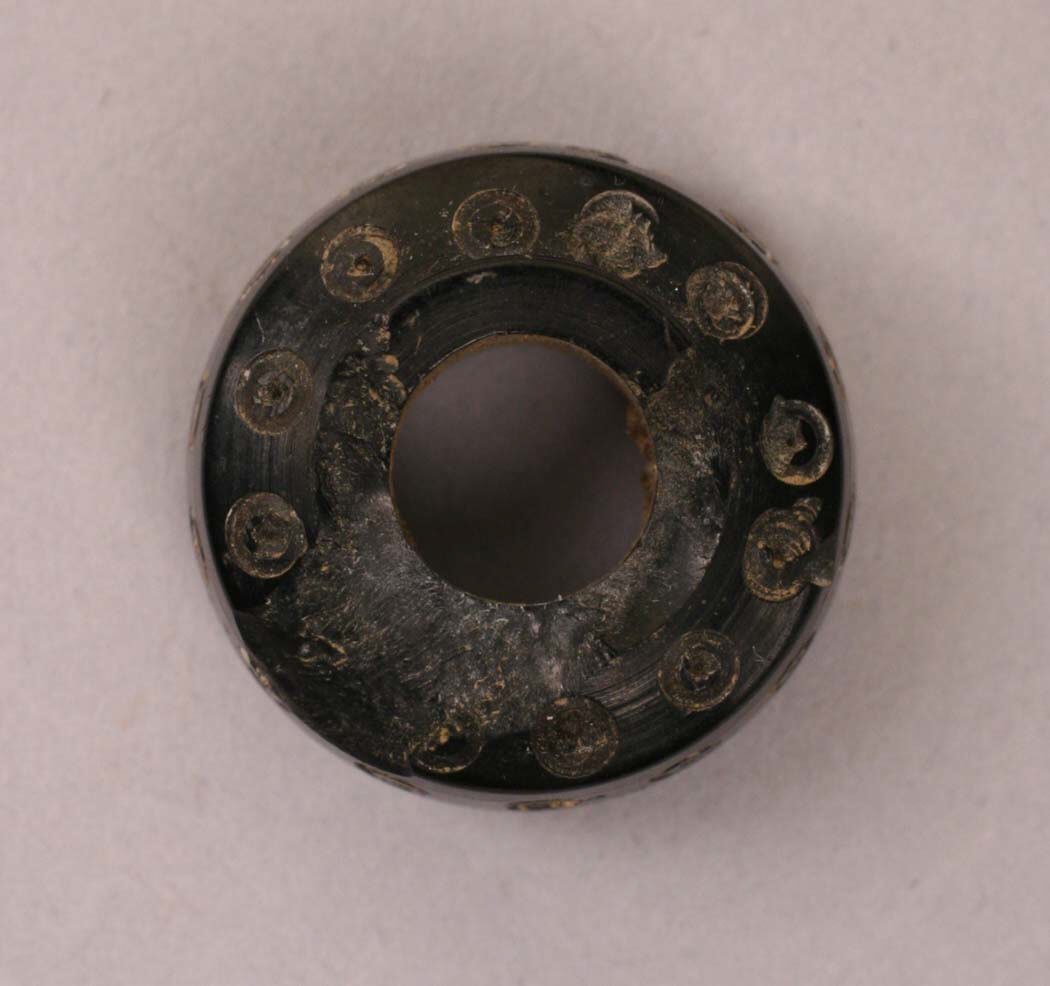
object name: button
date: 701-1000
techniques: carving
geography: iran